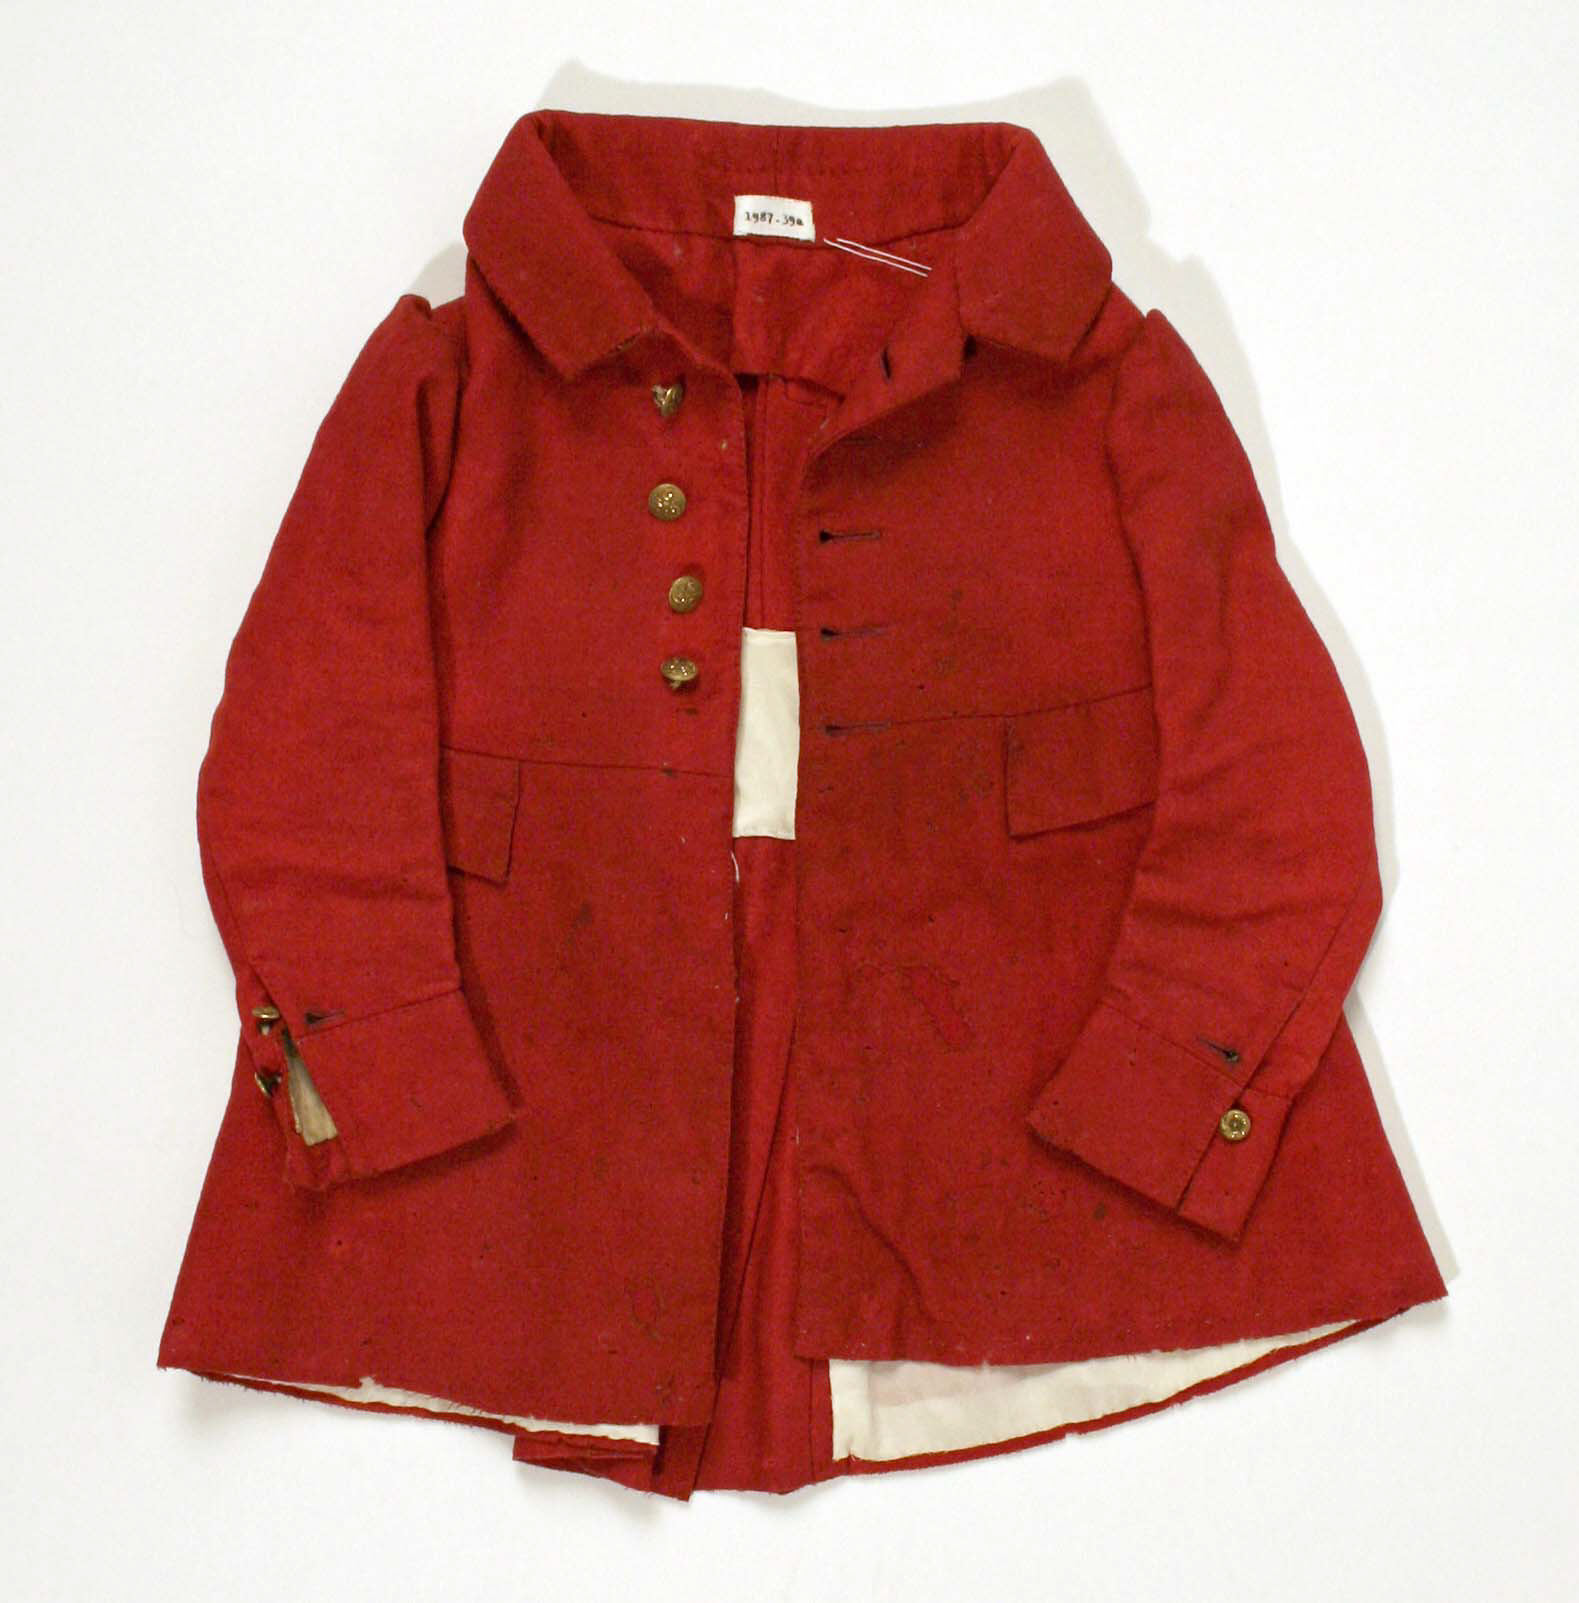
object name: hunting ensemble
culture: british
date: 1837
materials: leather, linen, silk, wool